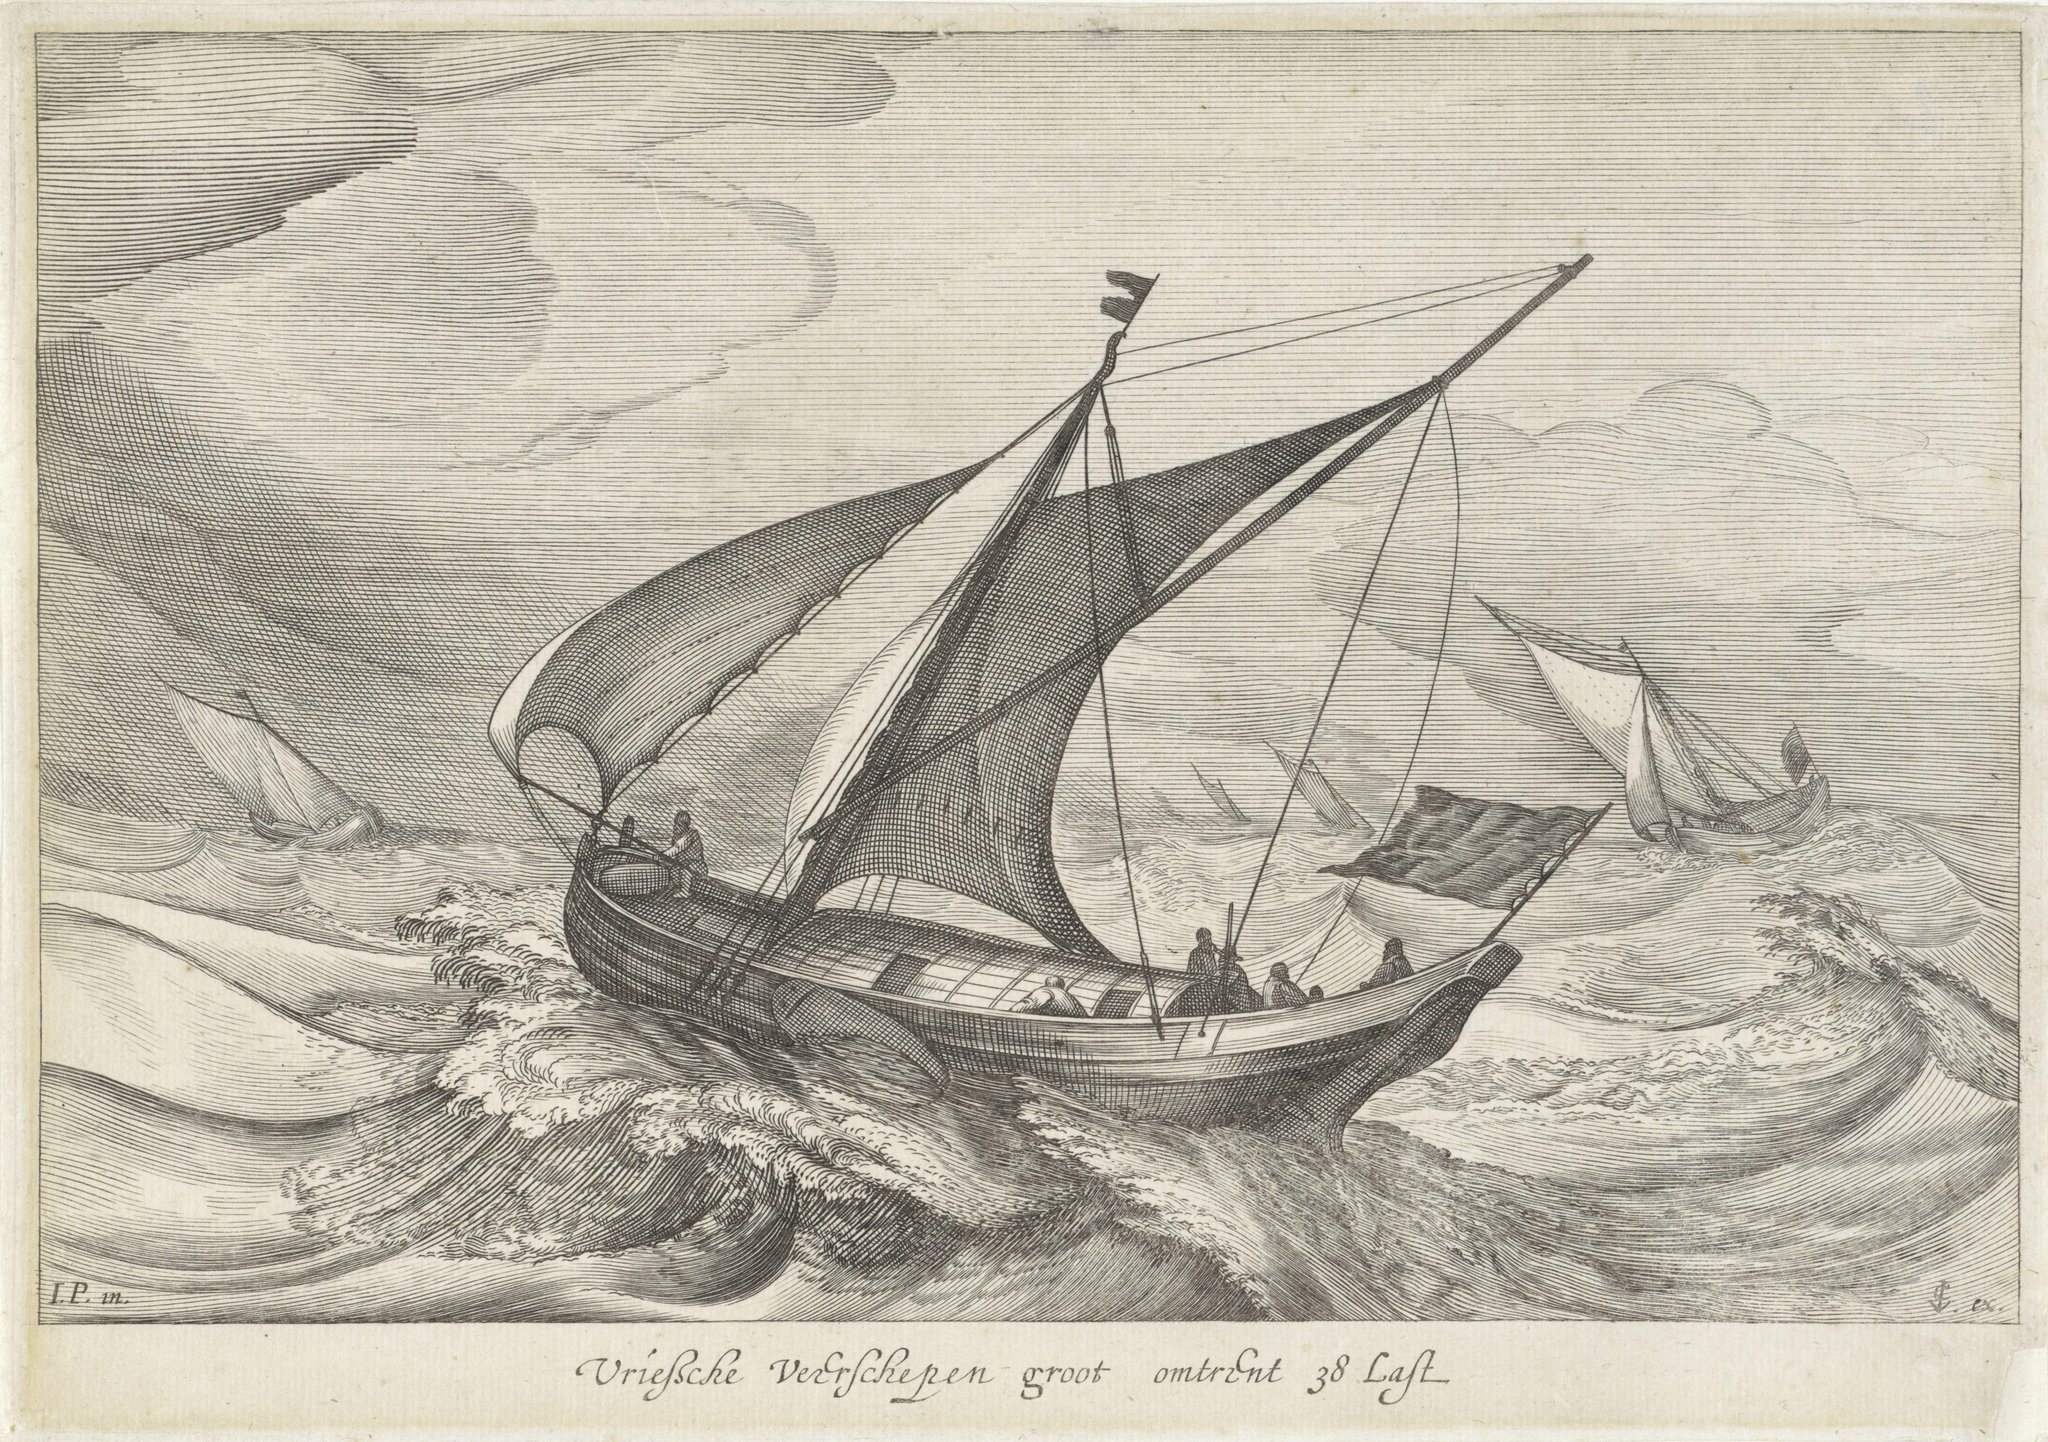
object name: print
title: Icones variarum navium Hollandicarum quarum usus maximè in aquis interioribus regionis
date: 1677-1702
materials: paper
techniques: engraving, etching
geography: low countries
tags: sailing-ship, sailing-boat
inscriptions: collector's mark: Lugt 2228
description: Enkele Friese veerschepen op een woelige zee.